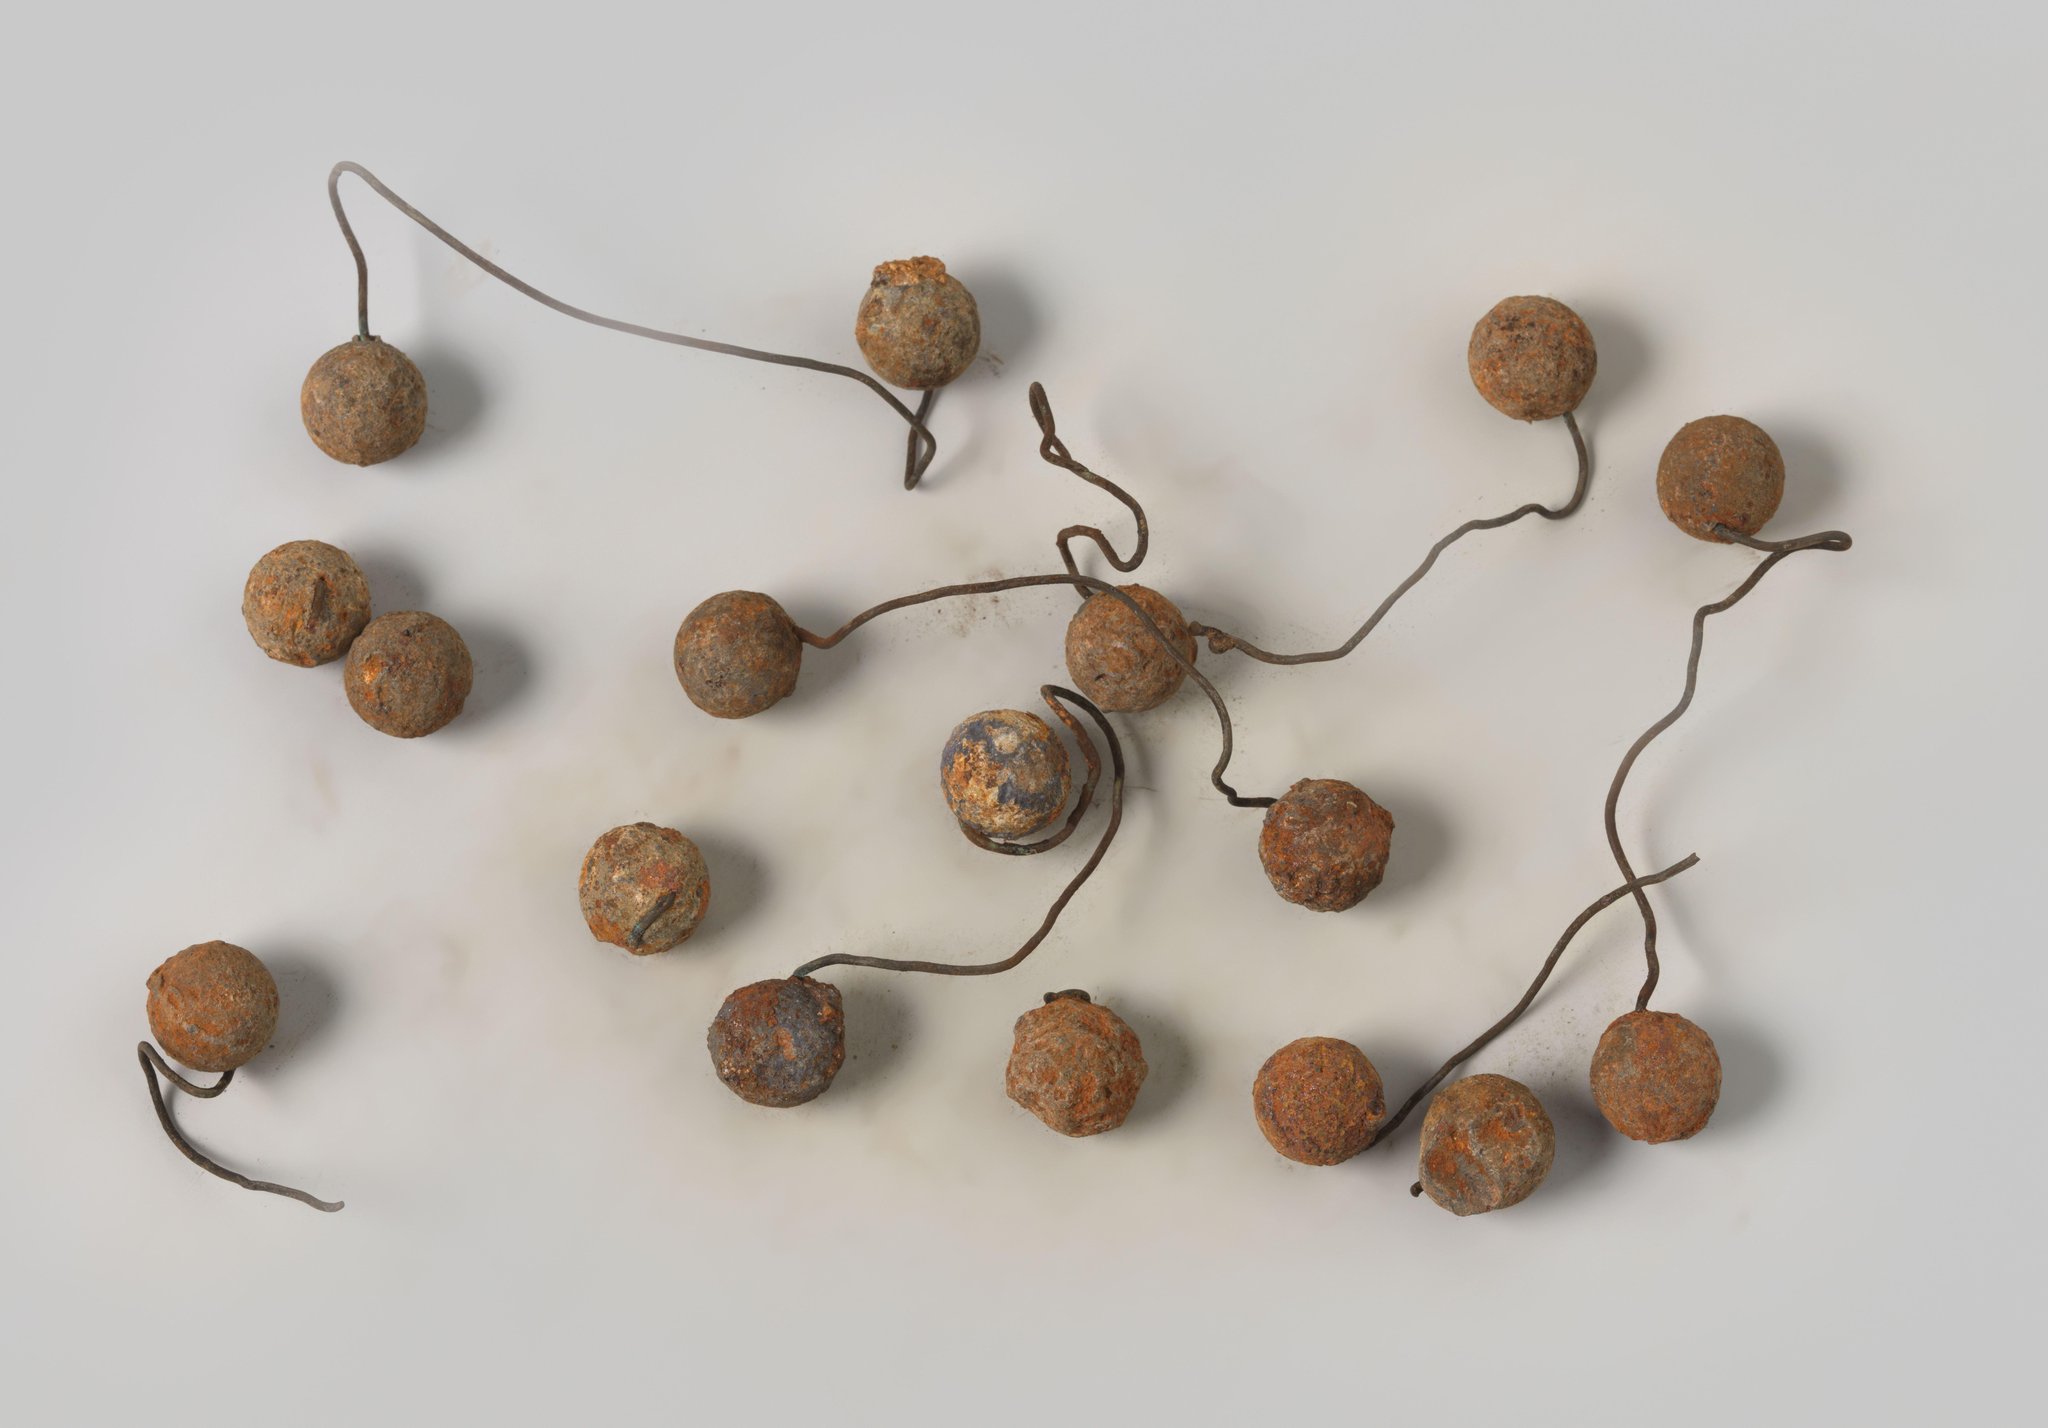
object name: chain shot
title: Kettingkogels en losse kogels uit het wrak van de Oost-Indiëvaarder Hollandia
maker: Anonymous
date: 1700-1743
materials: lead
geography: netherlands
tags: verenigde oostindische compagnie, hollandia (schip), annet